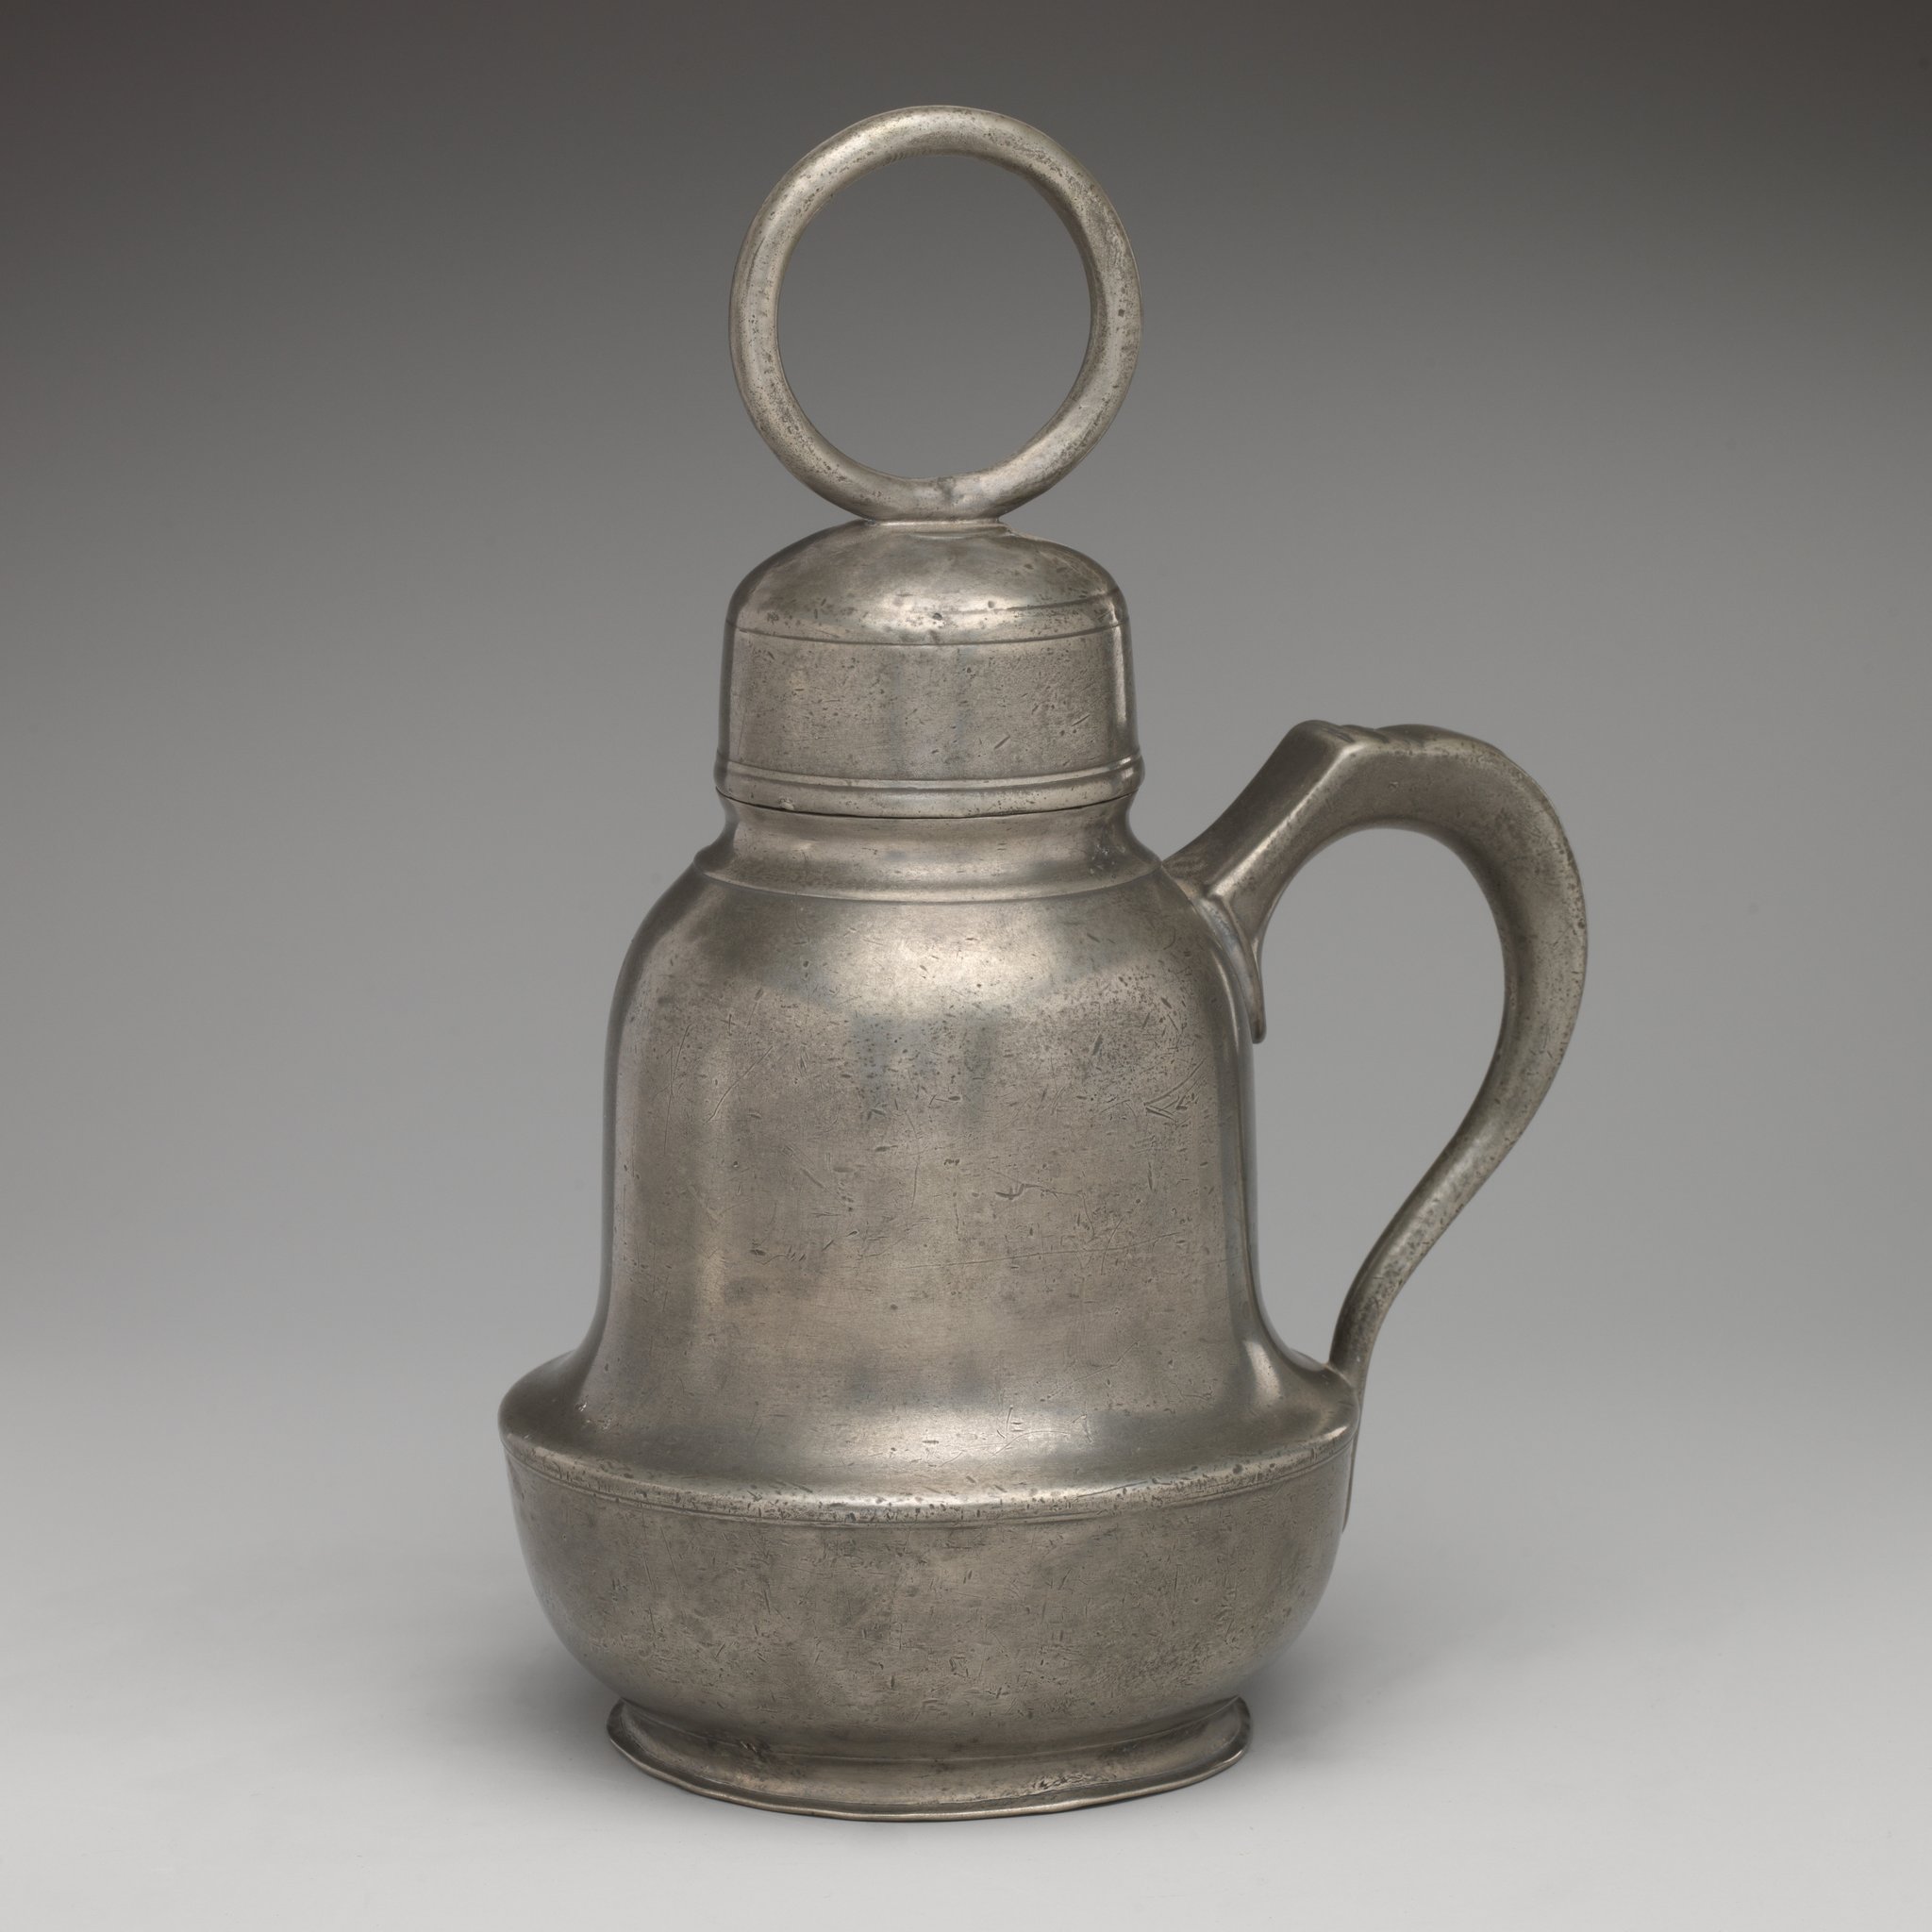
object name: food bottle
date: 1800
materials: pewter